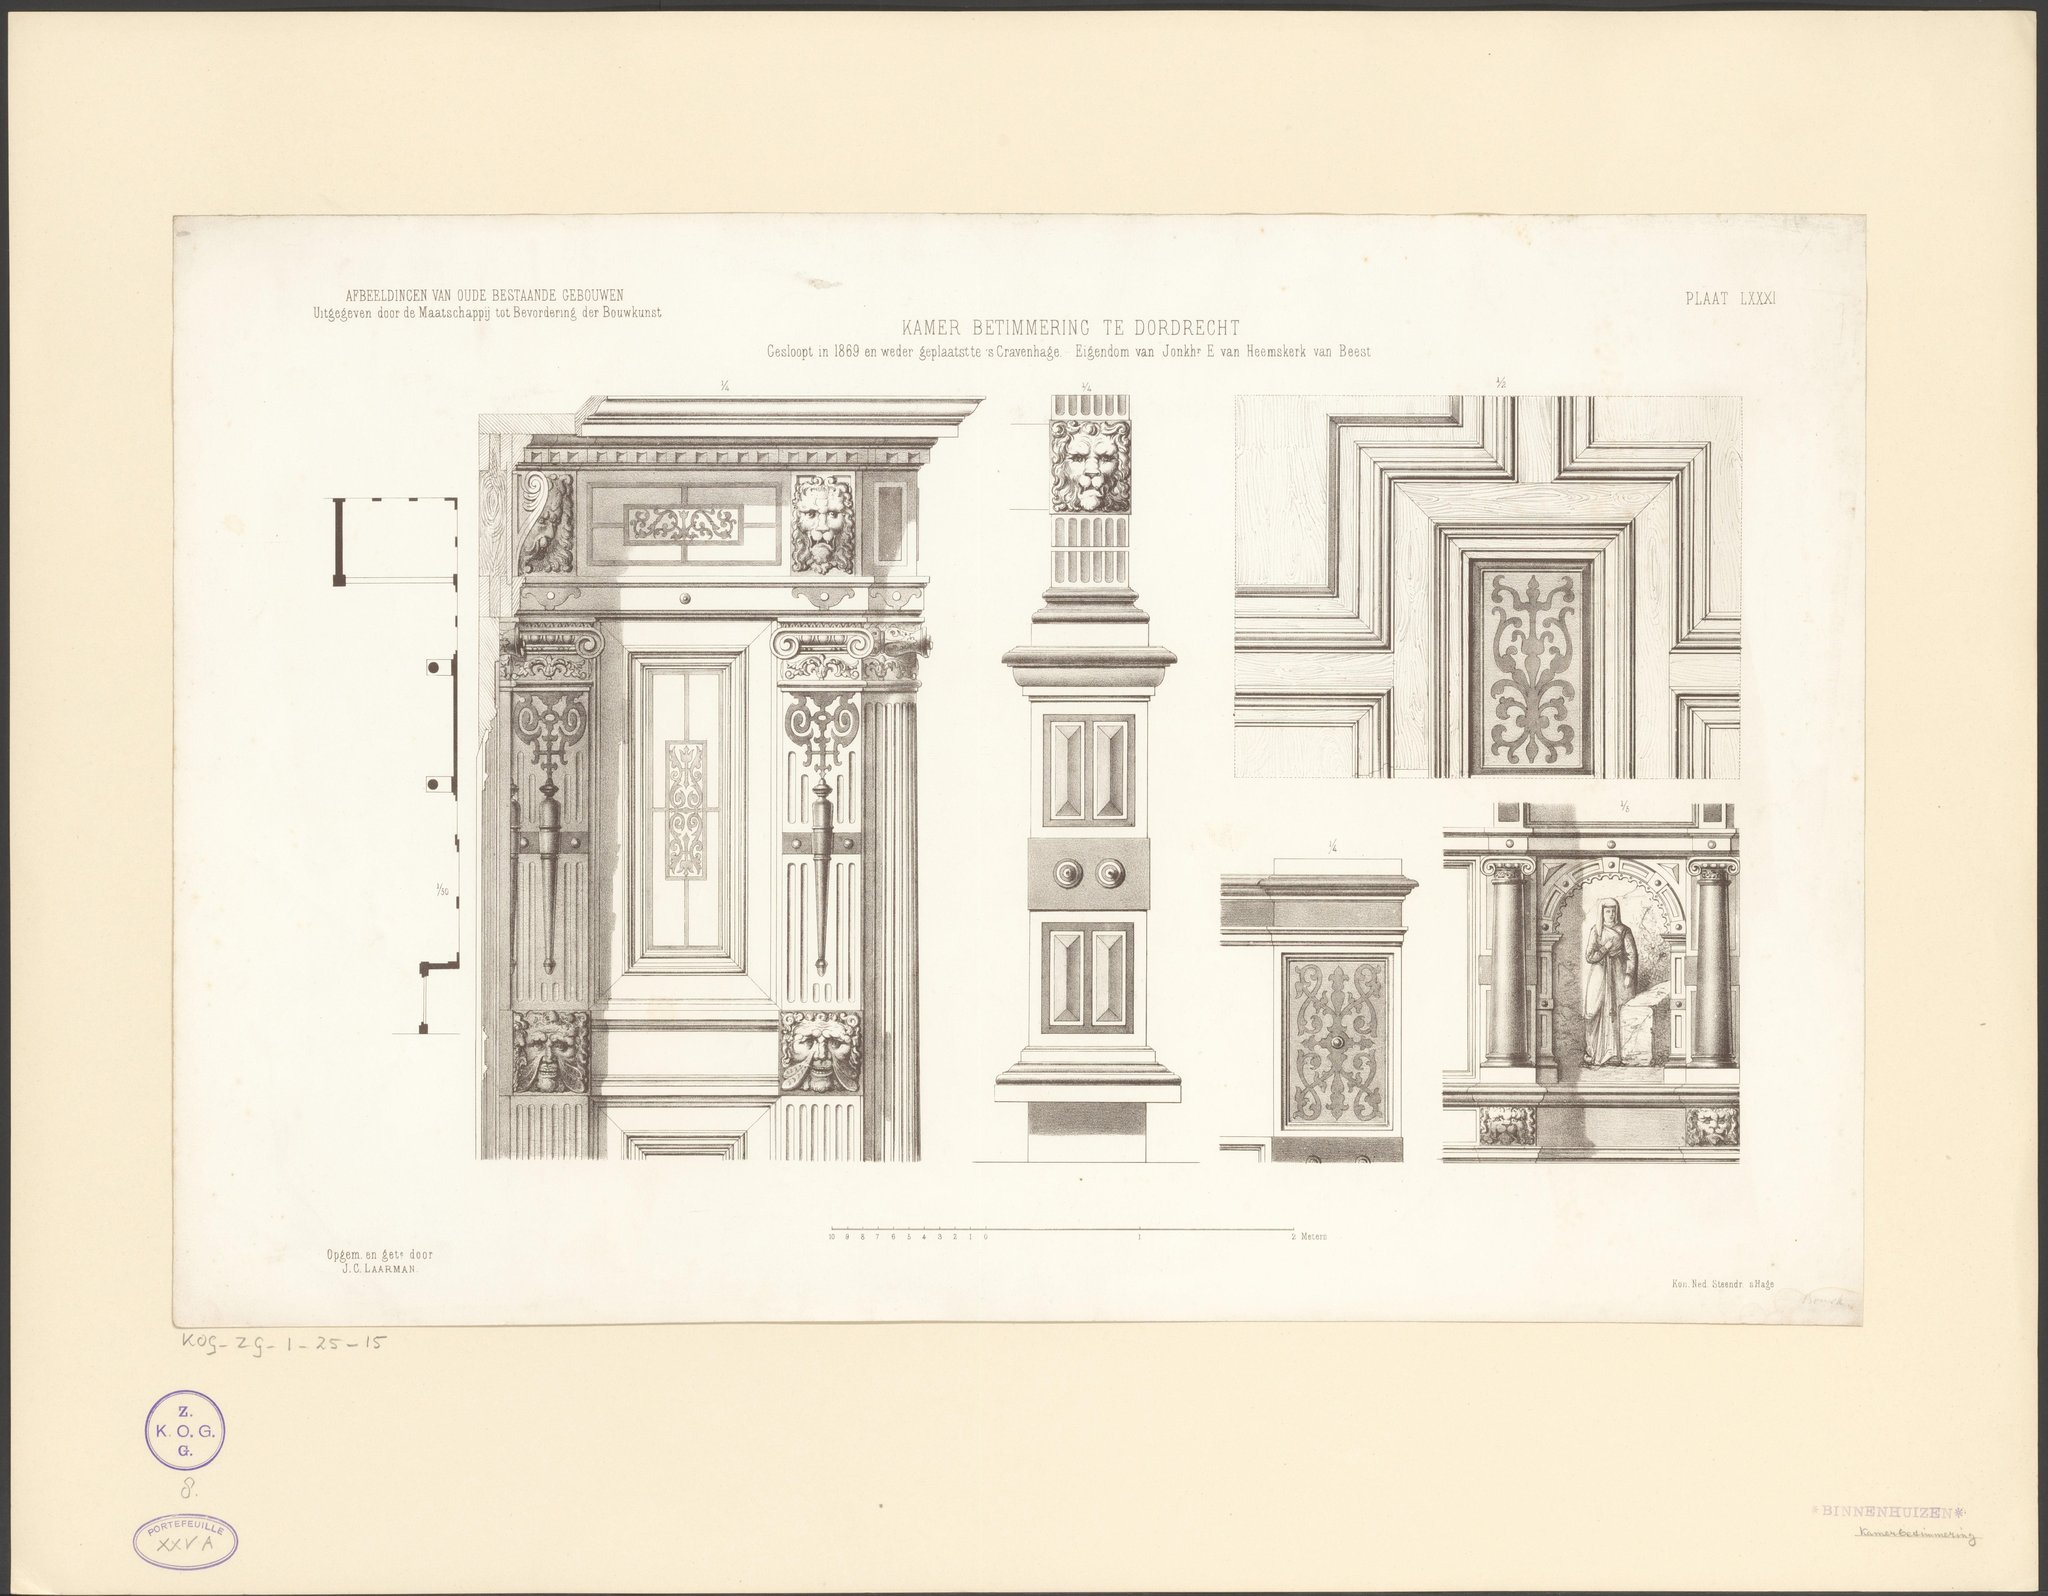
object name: print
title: Decoratie van de kamerbetimmering uit Dordrecht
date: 1869-1902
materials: paper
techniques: lithograph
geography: the hague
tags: panelling, wall-covering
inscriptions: collector's mark: Lugt 1641, stamp, stamp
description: Decoratie en plattegrond van de kamerbetimmering uit Dordrecht. De betimmering is in 1869 gesloopt en opgebouwd in Den Haag. Rechtsboven genummerd: Plaat LXXX. Onderaan een schaal. Onderwerpsrubrieken binnen de Atlas Zeden en Gewoonten: Zeden en Gewoonten in Engeren Zin, De Woning, Binnenhuizen, Kamerbetimmering.